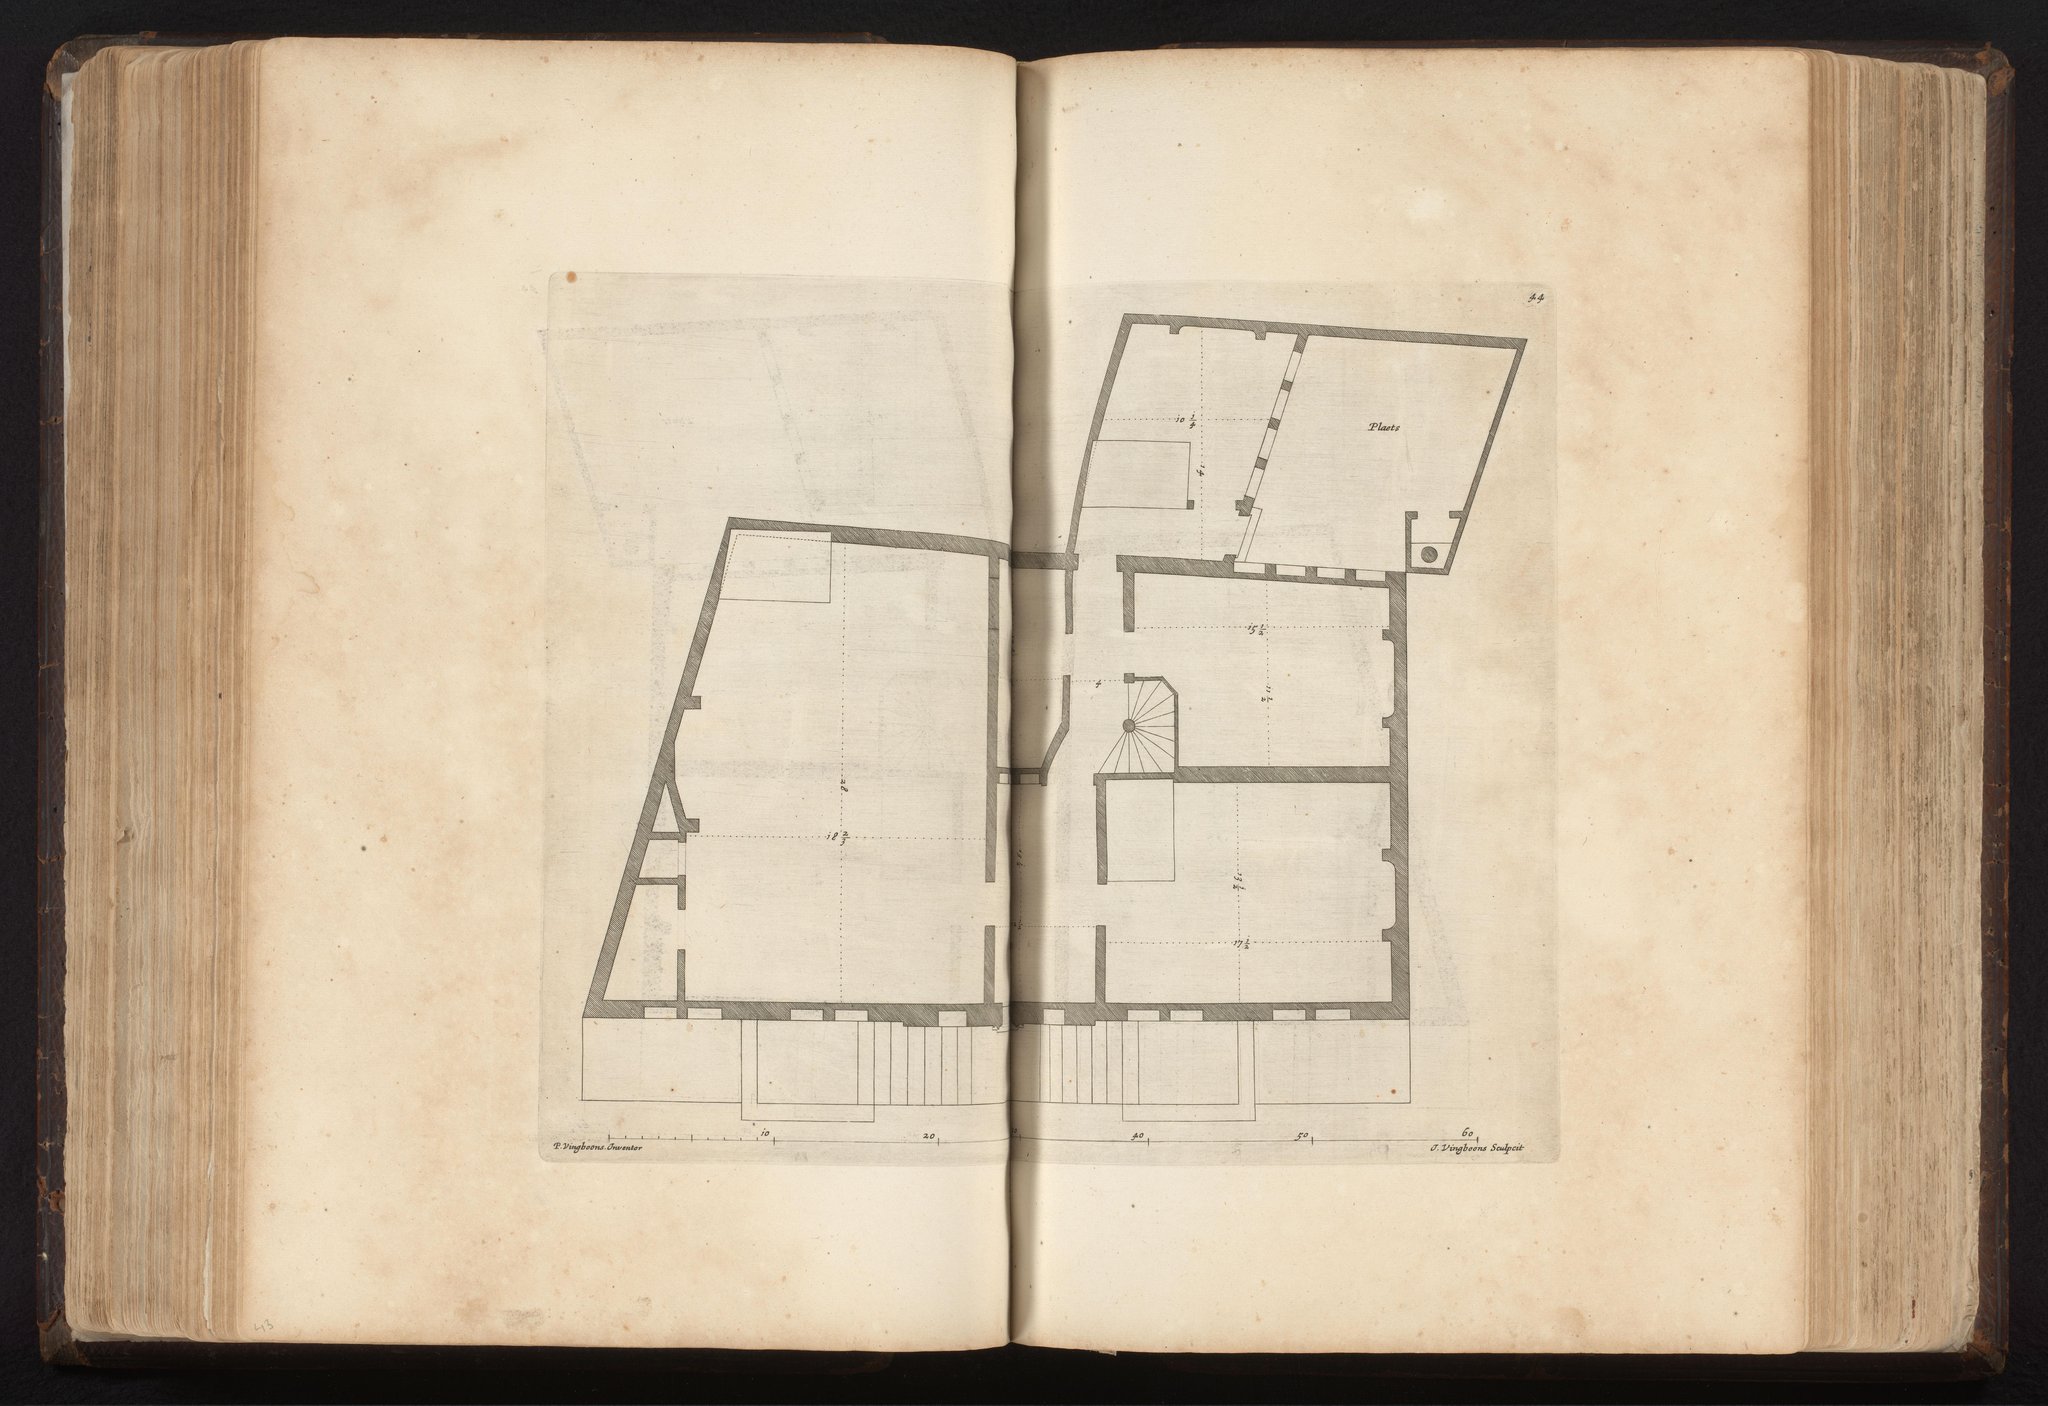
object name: book illustration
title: Plattegrond van een huis aan de Geldersekade te Amsterdam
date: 1648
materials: paper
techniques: engraving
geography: amsterdam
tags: plan ~ architecture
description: Prent uit: Afbeelsels der voornaemste gebouwen uyt alle die Philips Vingboons geordineert heeft. Amsterdam: Philips en Johannes Vinckboons en Johannes Willemszoon Blaeu, 1648.